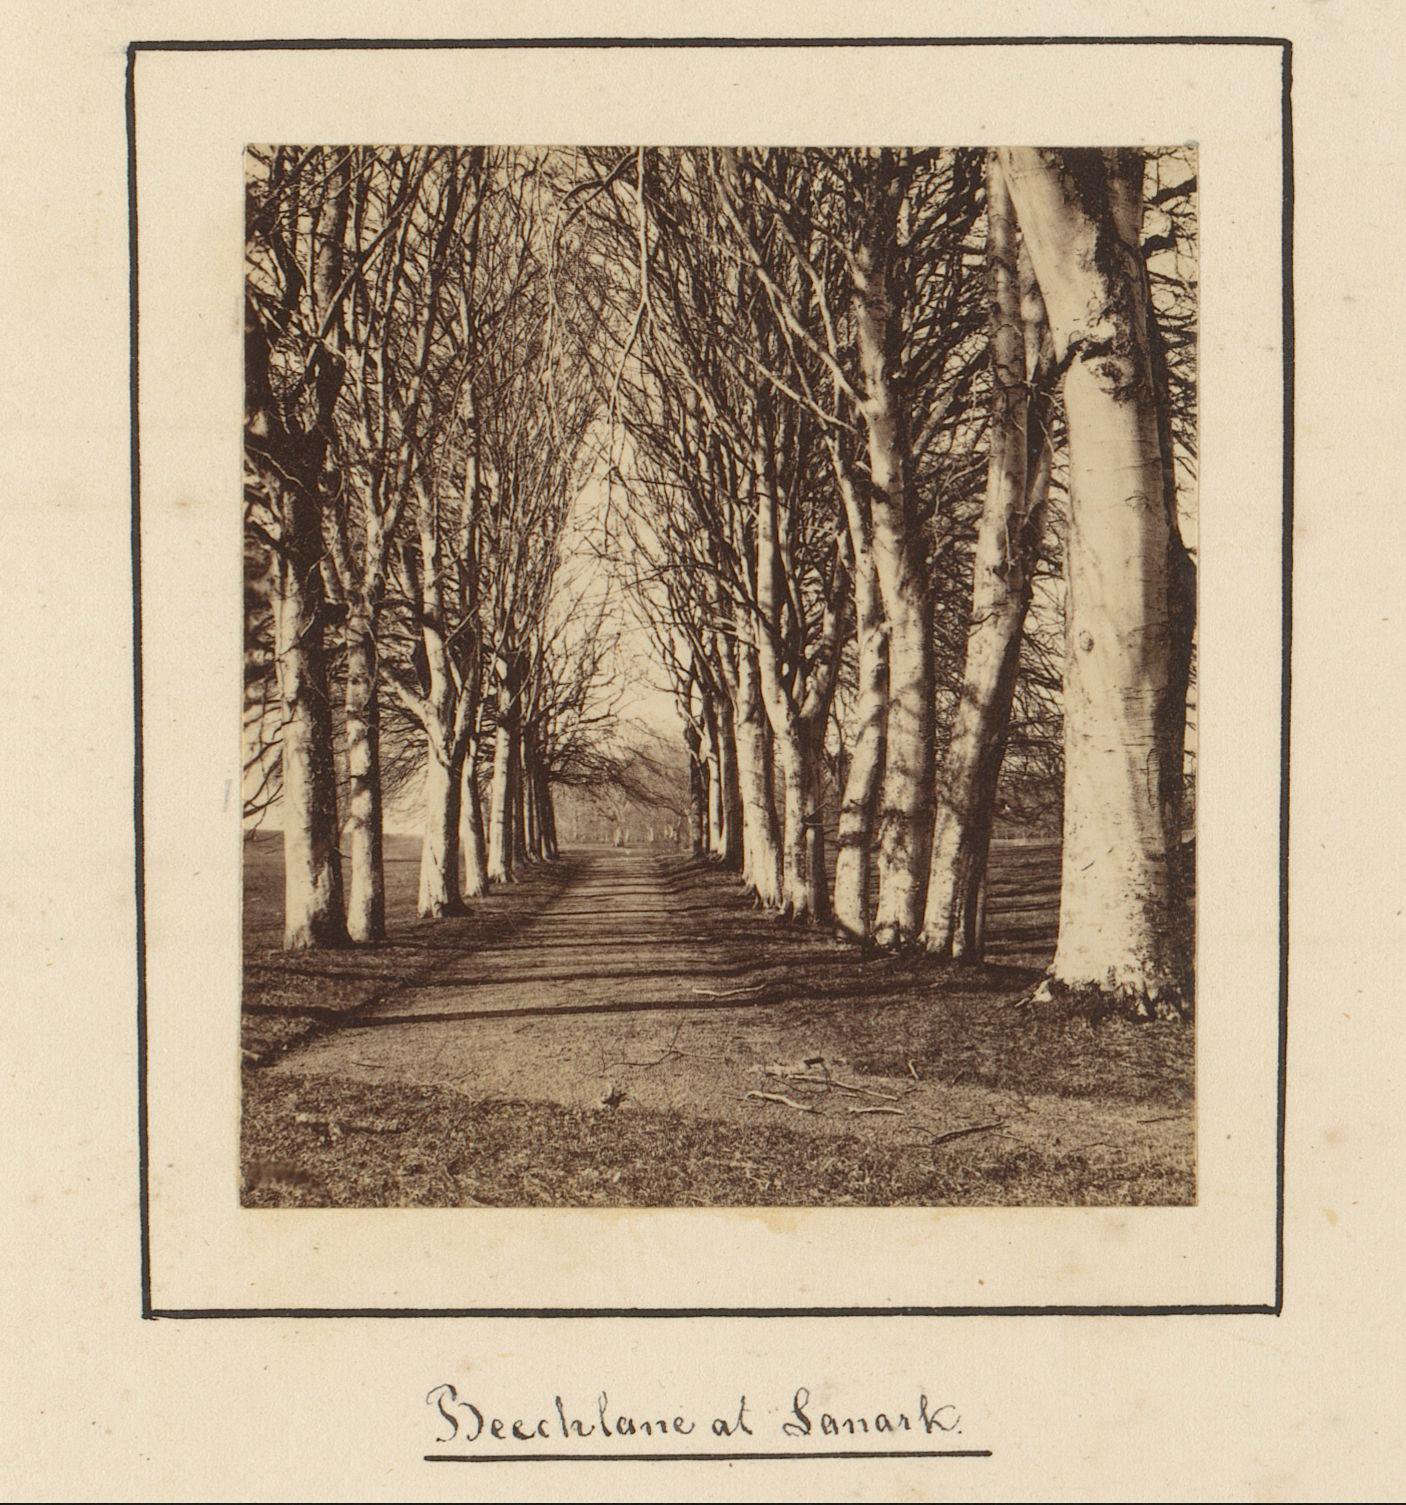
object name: photograph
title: Beechlane at Lanark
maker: Anonymous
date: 1870-1890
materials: paper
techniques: albumen print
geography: lanark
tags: trees: beech, forest path or lane